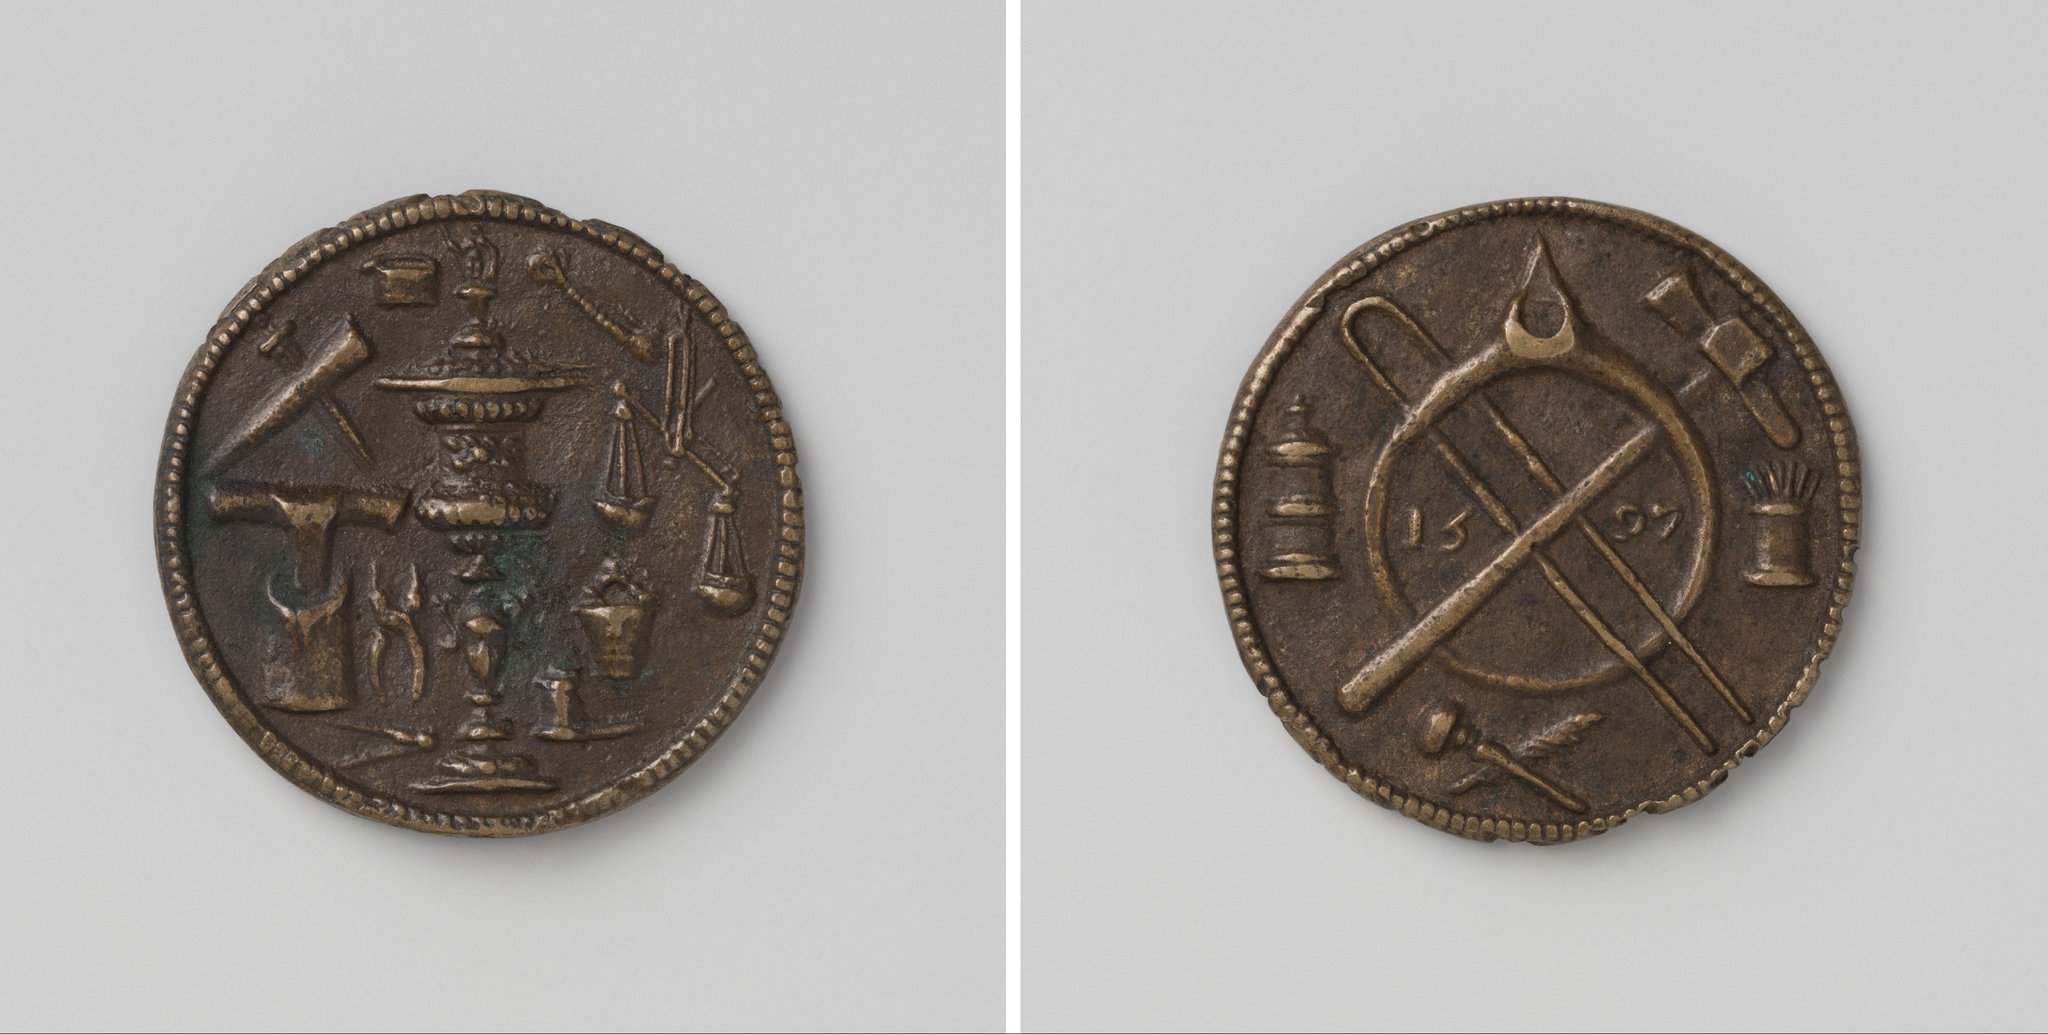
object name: medal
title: Zilversmedengilde van Antwerpen, gildepenning met no. 64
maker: Anonymous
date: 1597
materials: brass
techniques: casting, engraving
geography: antwerp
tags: antwerp